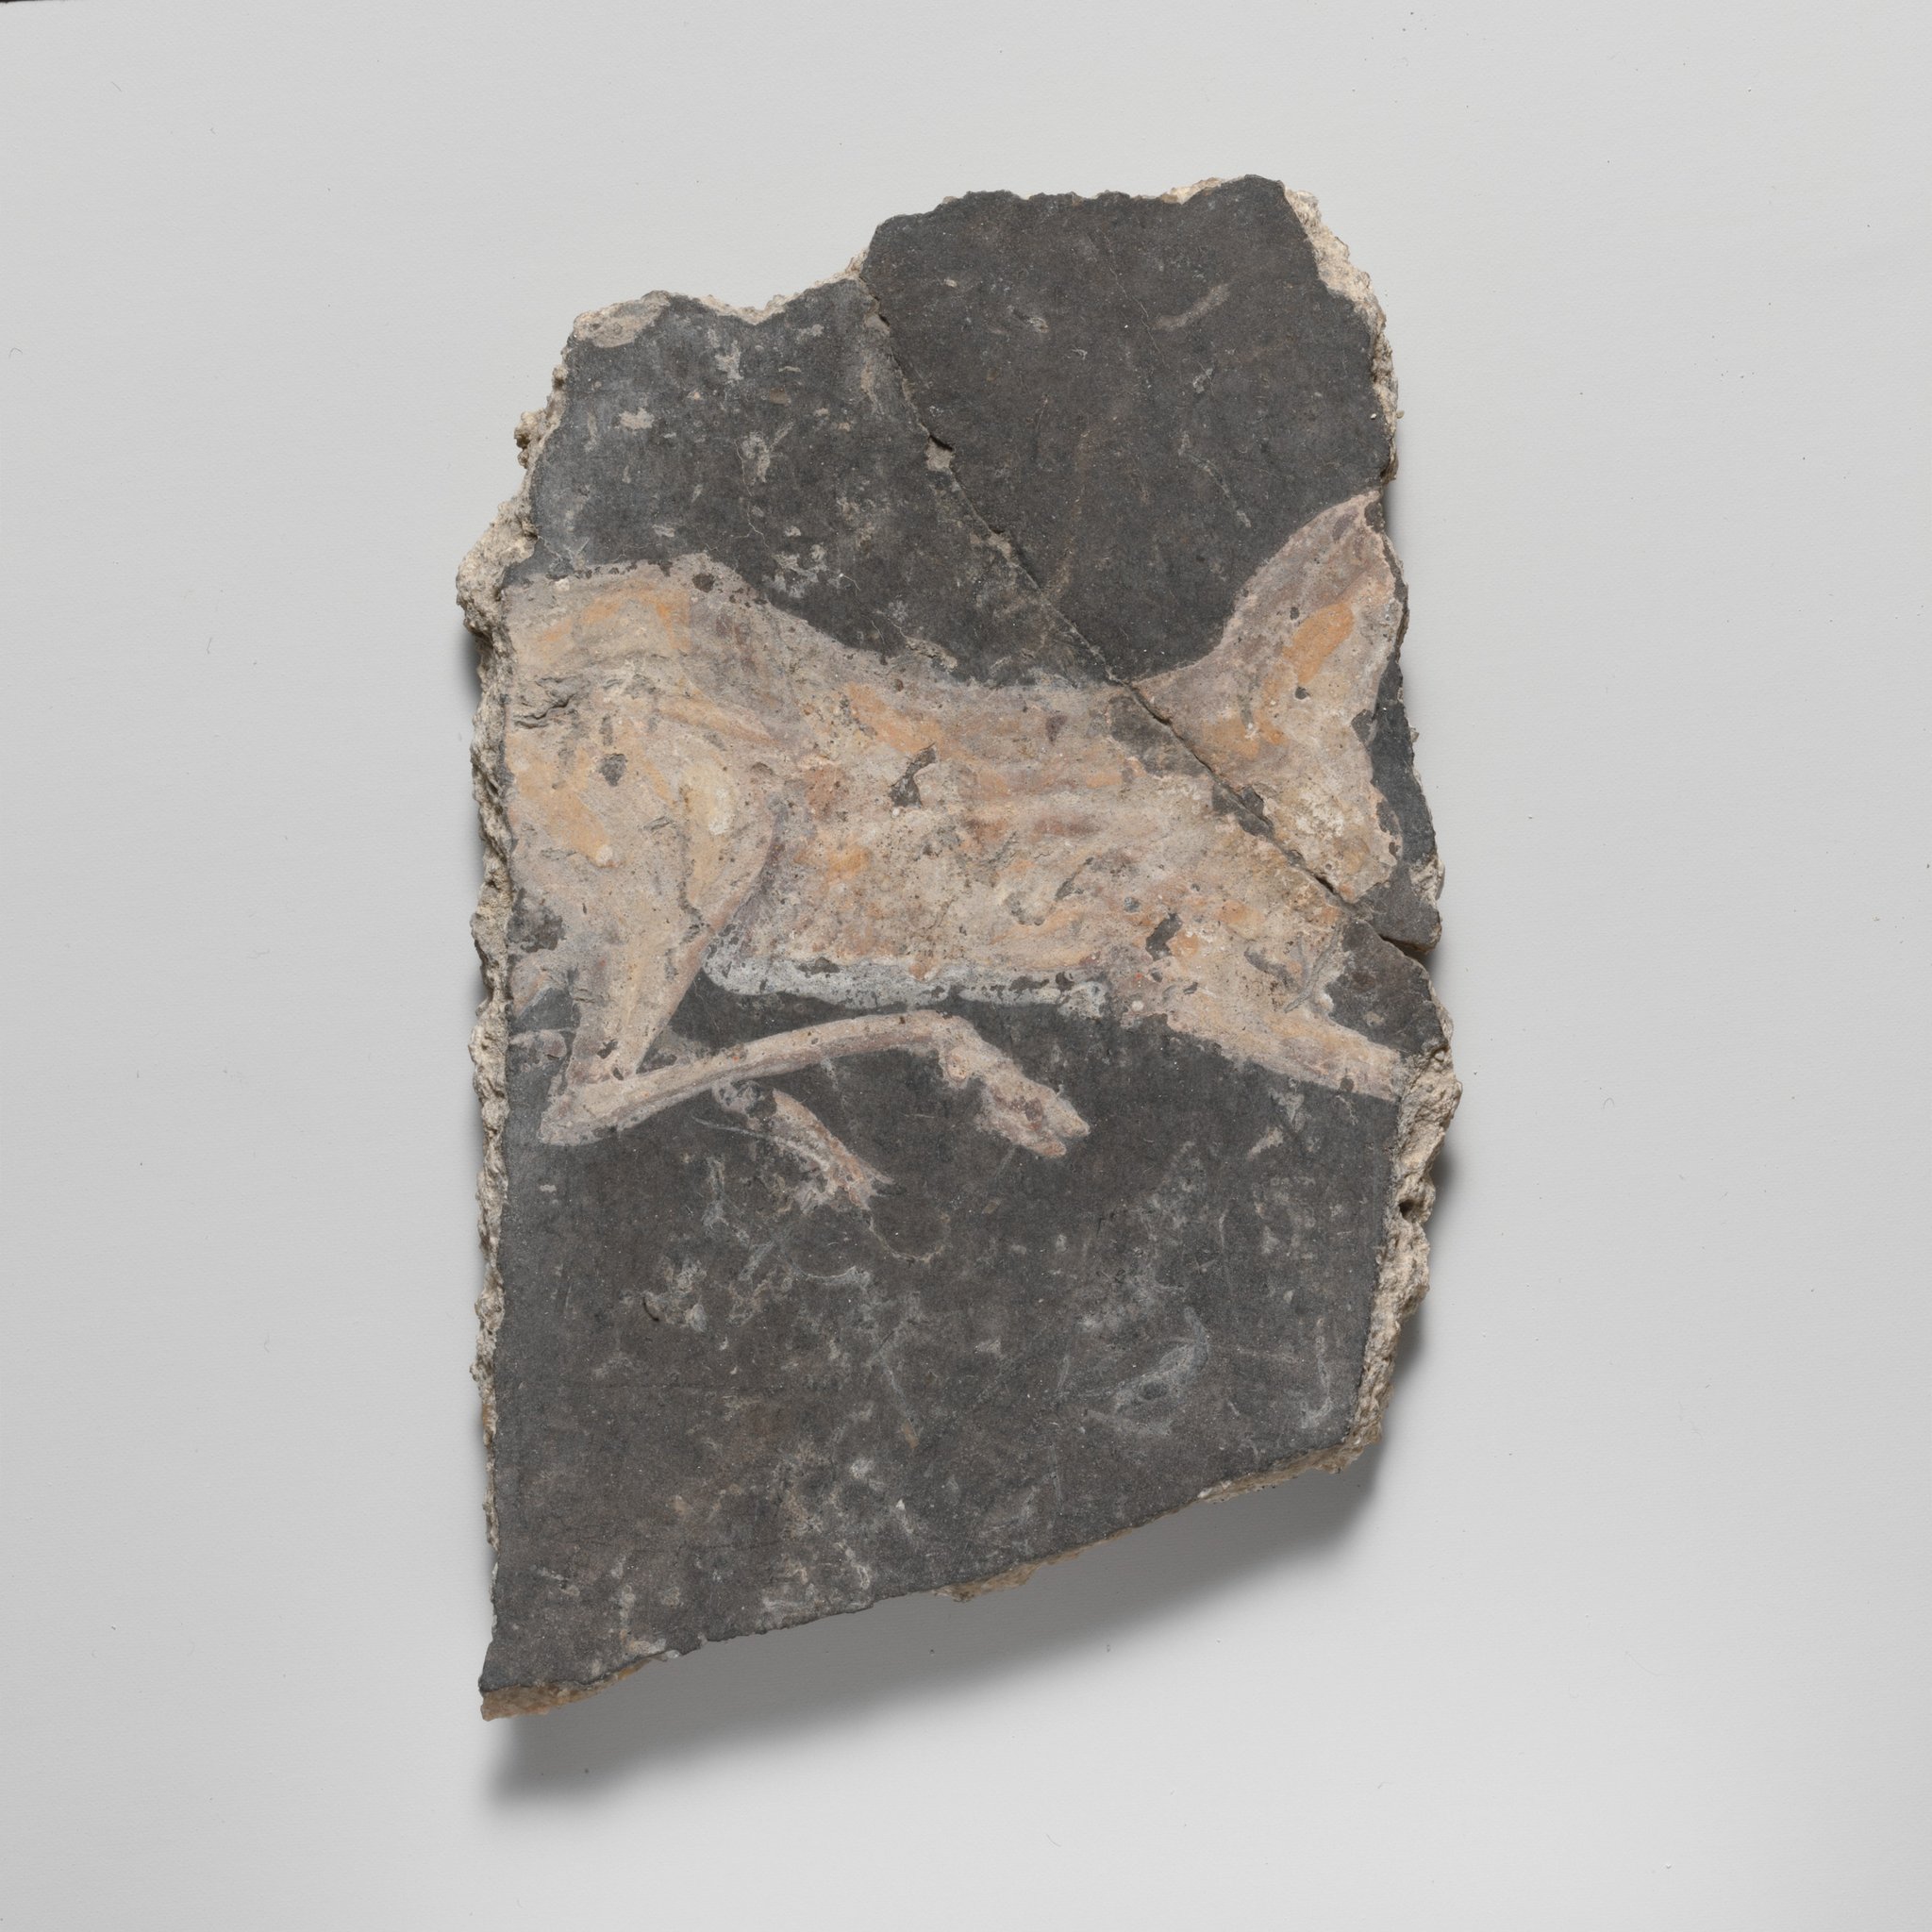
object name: wall painting fragment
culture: roman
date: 1-100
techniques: fresco